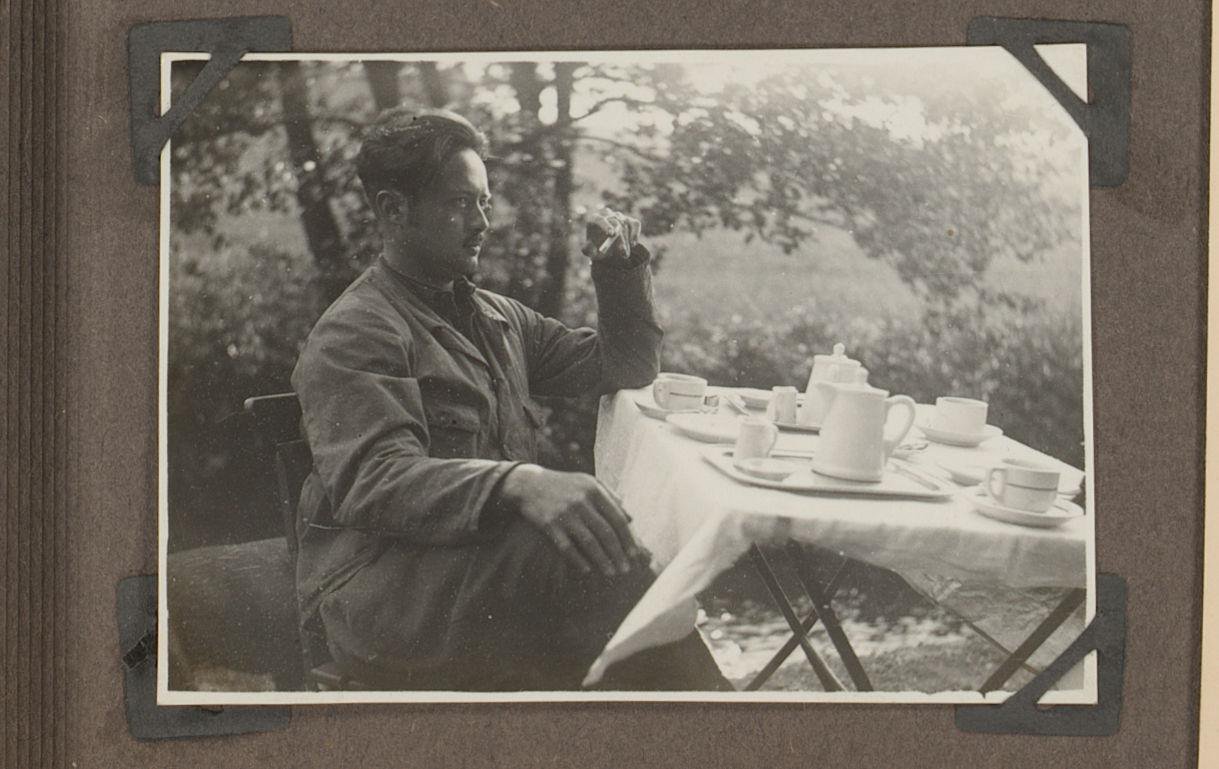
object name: photograph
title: Johannes van Zijll de Jong rokend aan theetafel in tuin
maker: Anonymous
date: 1930-1935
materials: paper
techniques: gelatin silver print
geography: netherlands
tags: cigarette, adult man, cup of tea, netherlands